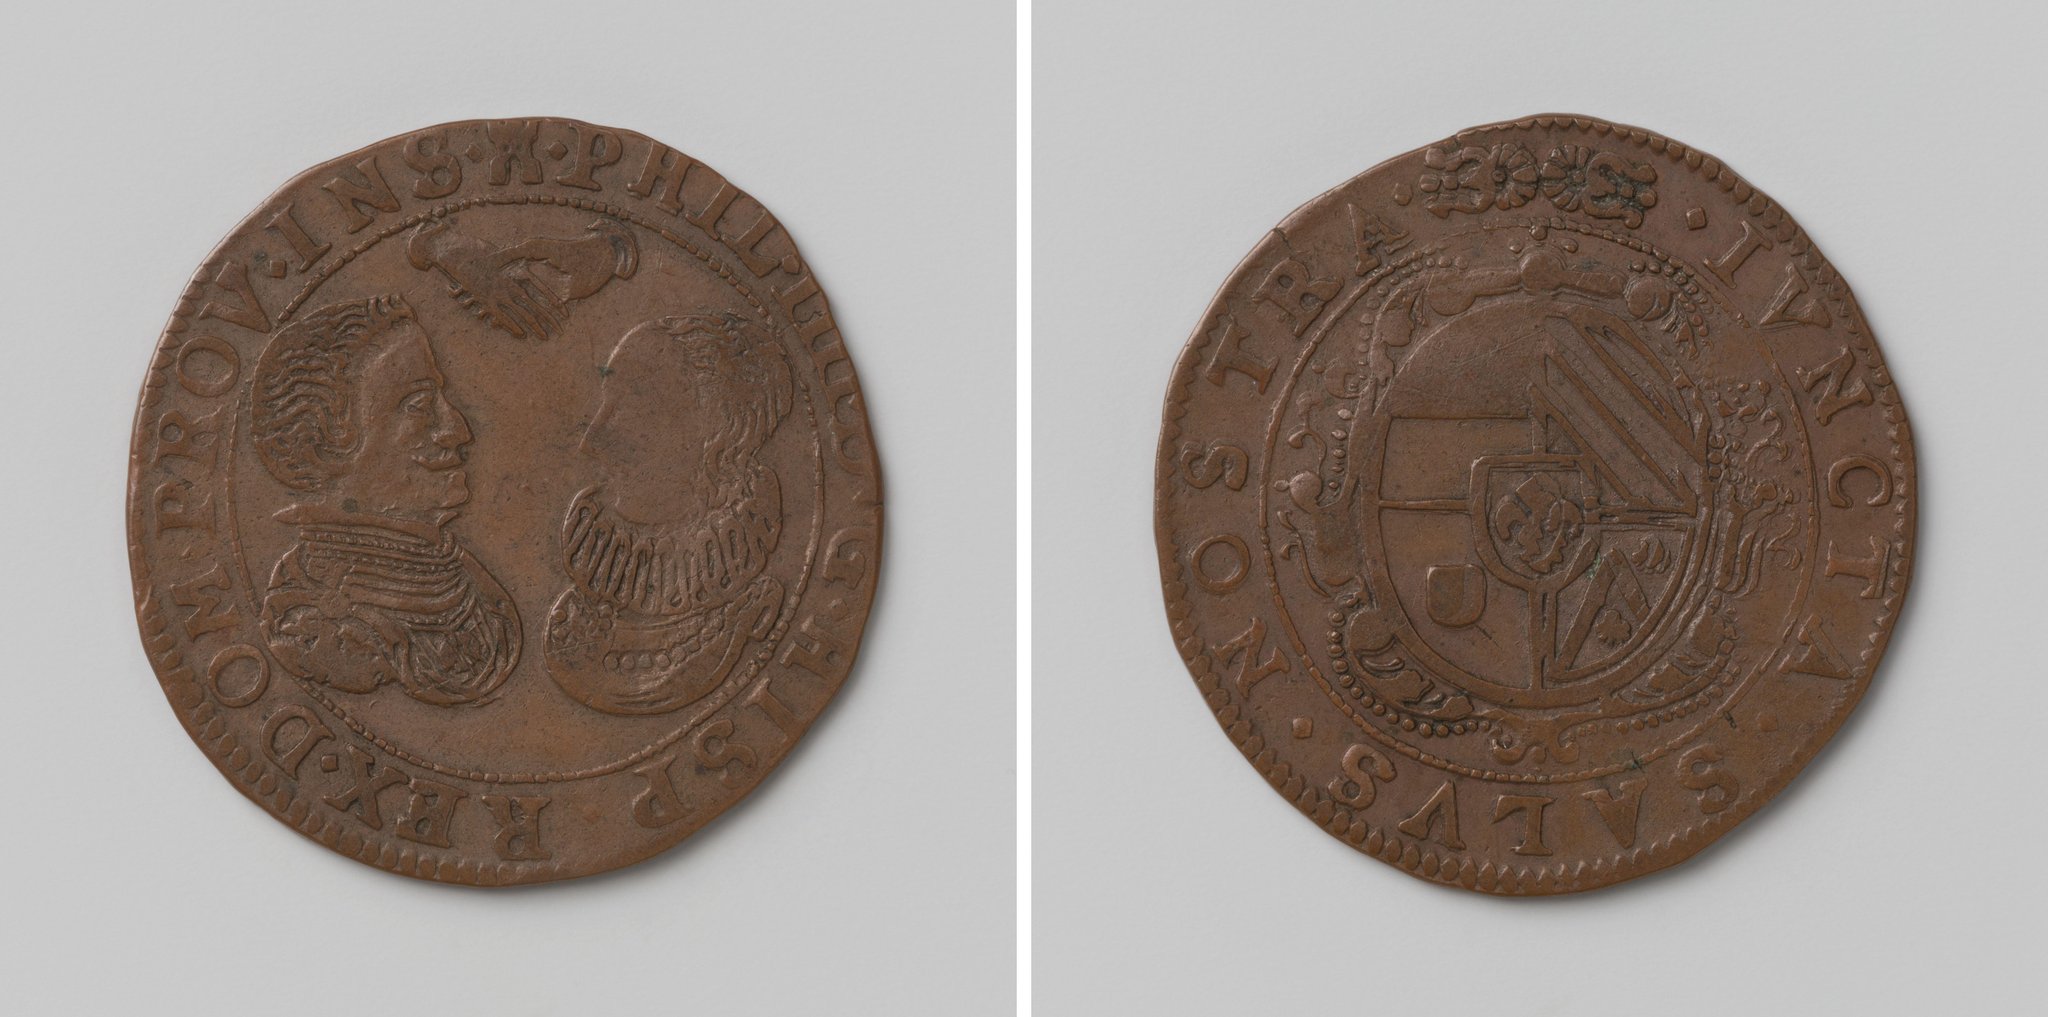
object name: jeton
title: Huwelijk van Filips IV, koning van Spanje en Maria Anna, aartshertogin van Oostenrijk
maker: Anonymous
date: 1649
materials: copper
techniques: striking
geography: belgium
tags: filips iv (koning van spanje), vienna, maria anna van oostenrijk (koningin van spanje), lille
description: Koperen penning. Voorzijde: naar elkaar gewende borststukken van man en vrouw onder twee ineen geslagen handen binnen omschrift. Keerzijde: wapenschild in cartouche binnen omschrift.